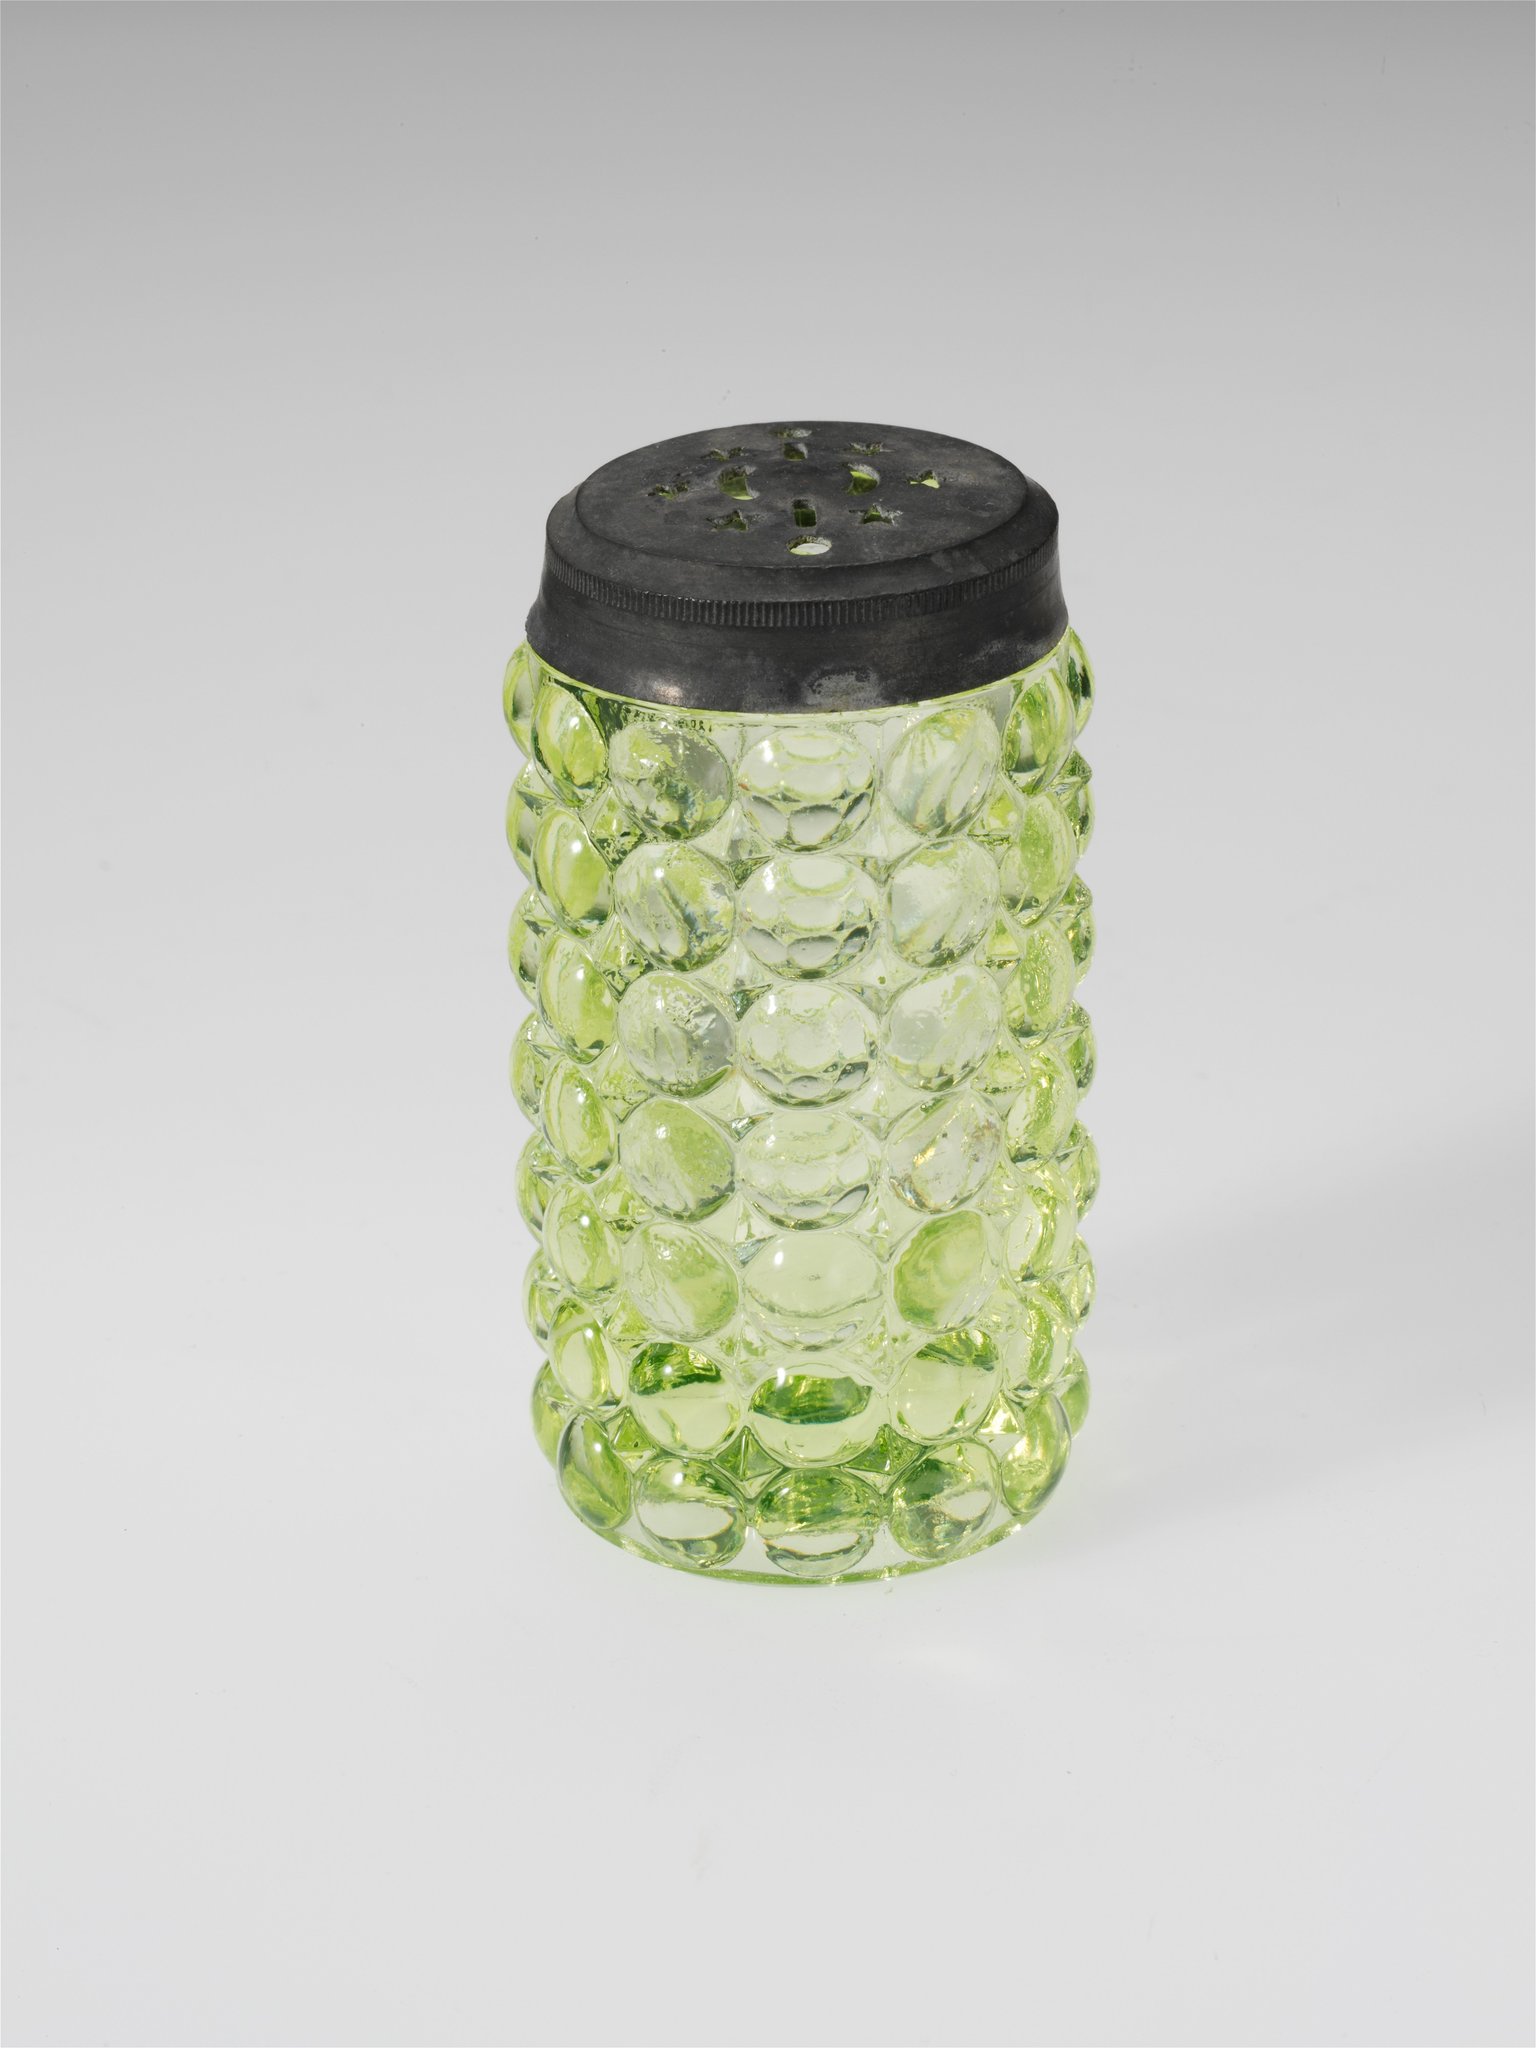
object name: pepper caster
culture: american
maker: richards and hartley flint glass co.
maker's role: maker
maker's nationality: american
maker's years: 1867-1890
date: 1888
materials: glass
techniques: pressed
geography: united states